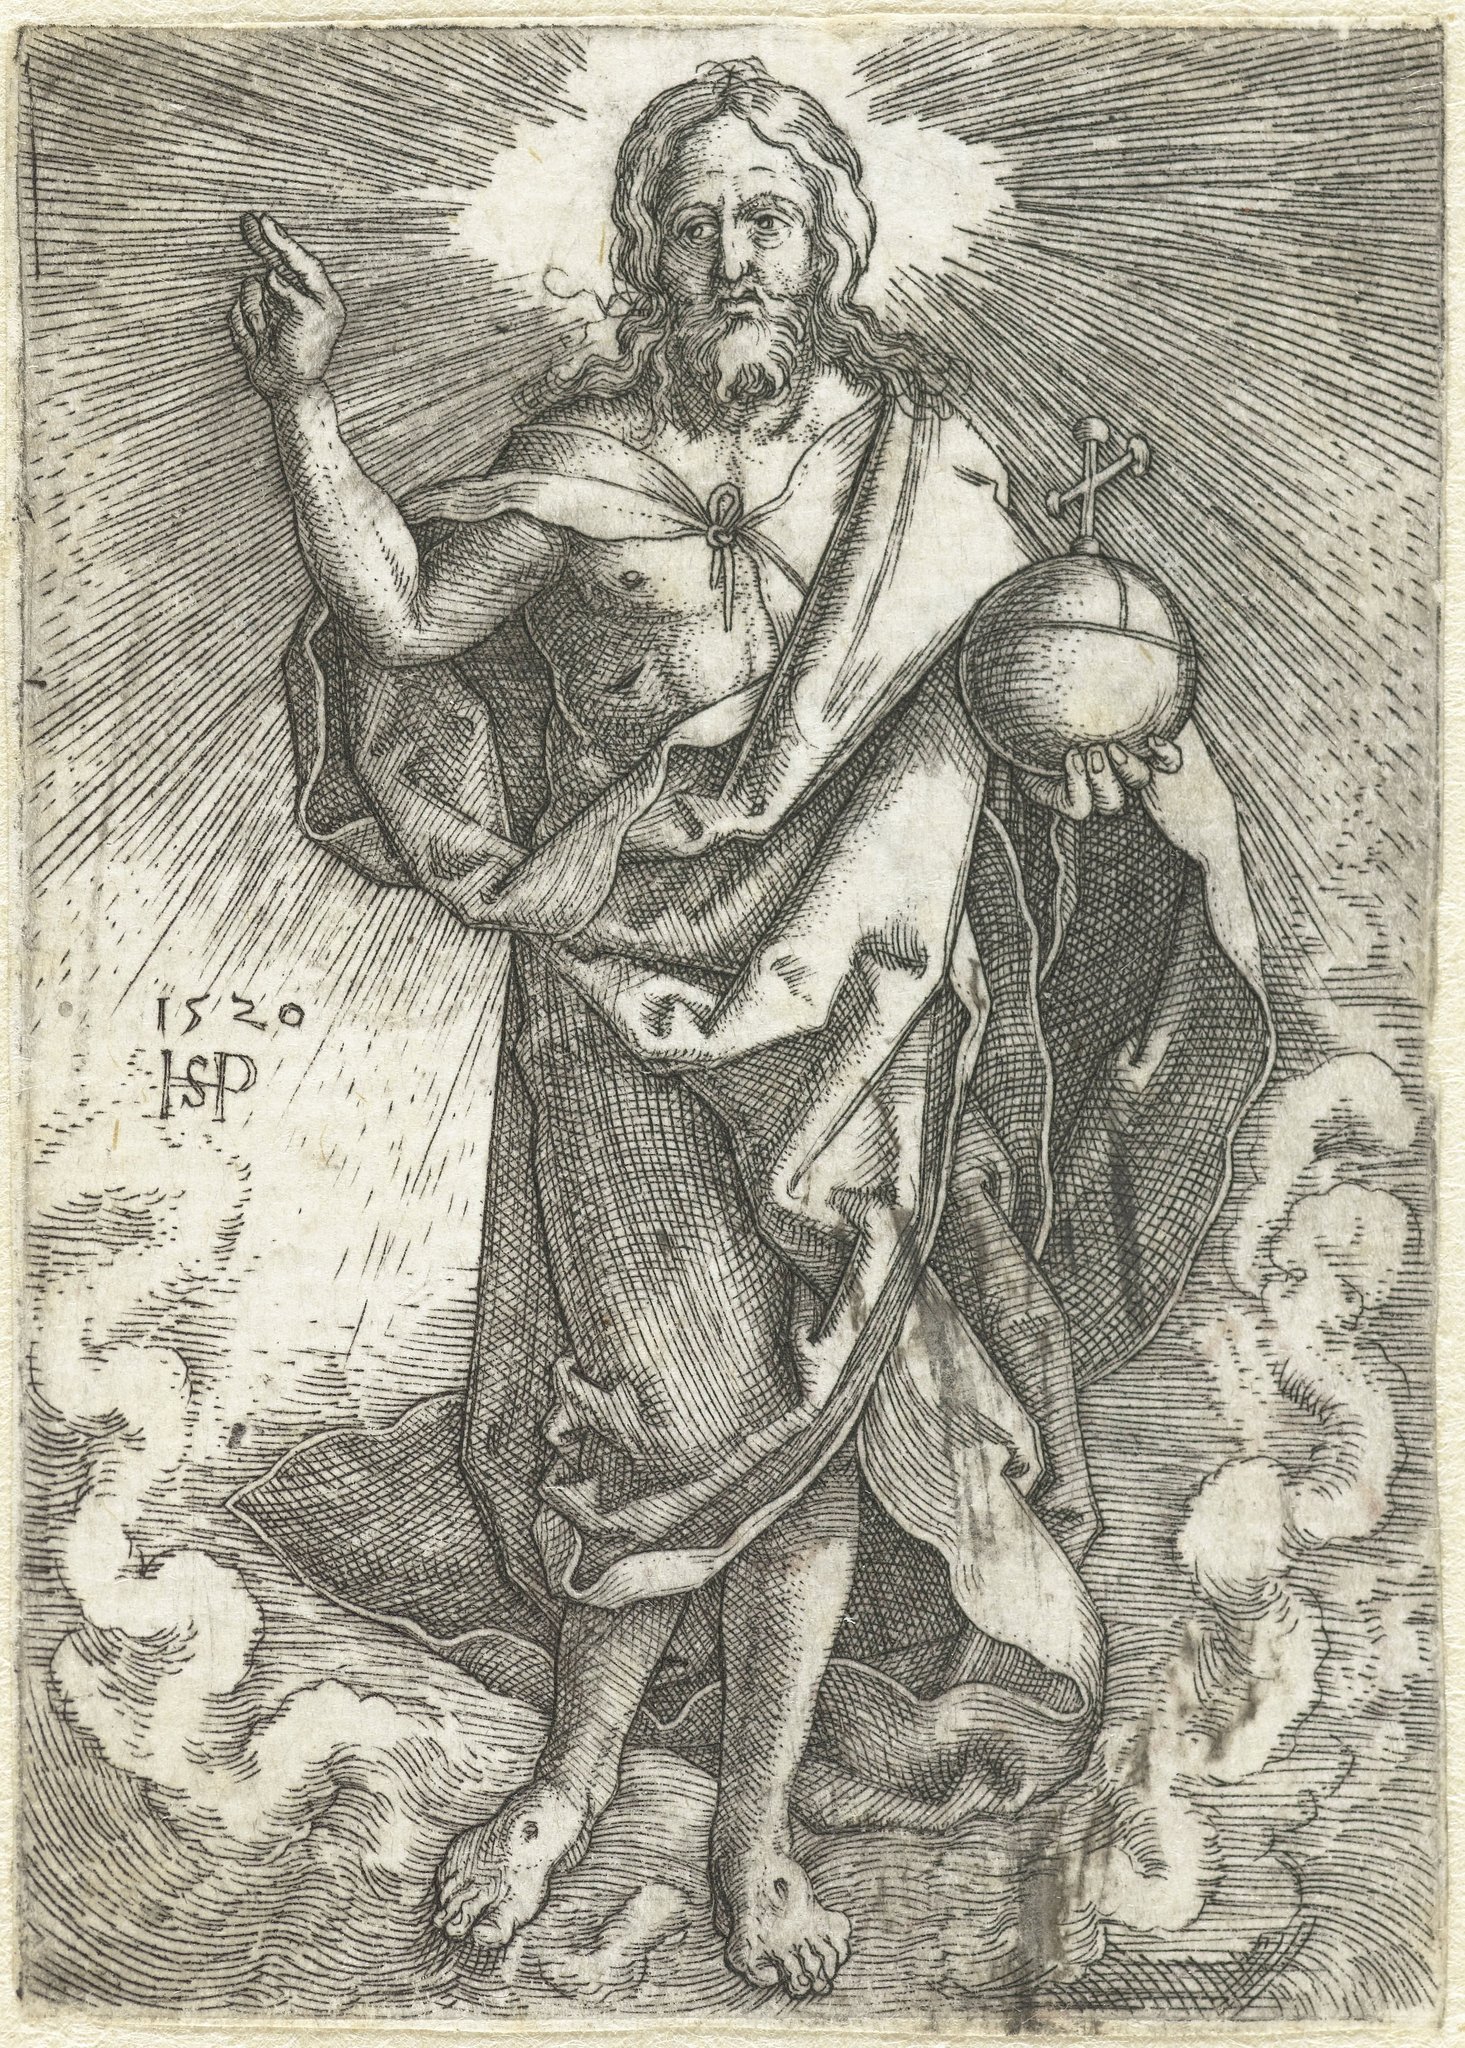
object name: print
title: Christus als Salvator Mundi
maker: hans sebald beham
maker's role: designer, draughtsman, print maker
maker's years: 1500-1550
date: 1520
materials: paper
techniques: engraving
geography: nuremberg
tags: 'salvator mundi', making a blessing gesture; an orb in his hand or at his feet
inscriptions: collector's mark: Lugt 240